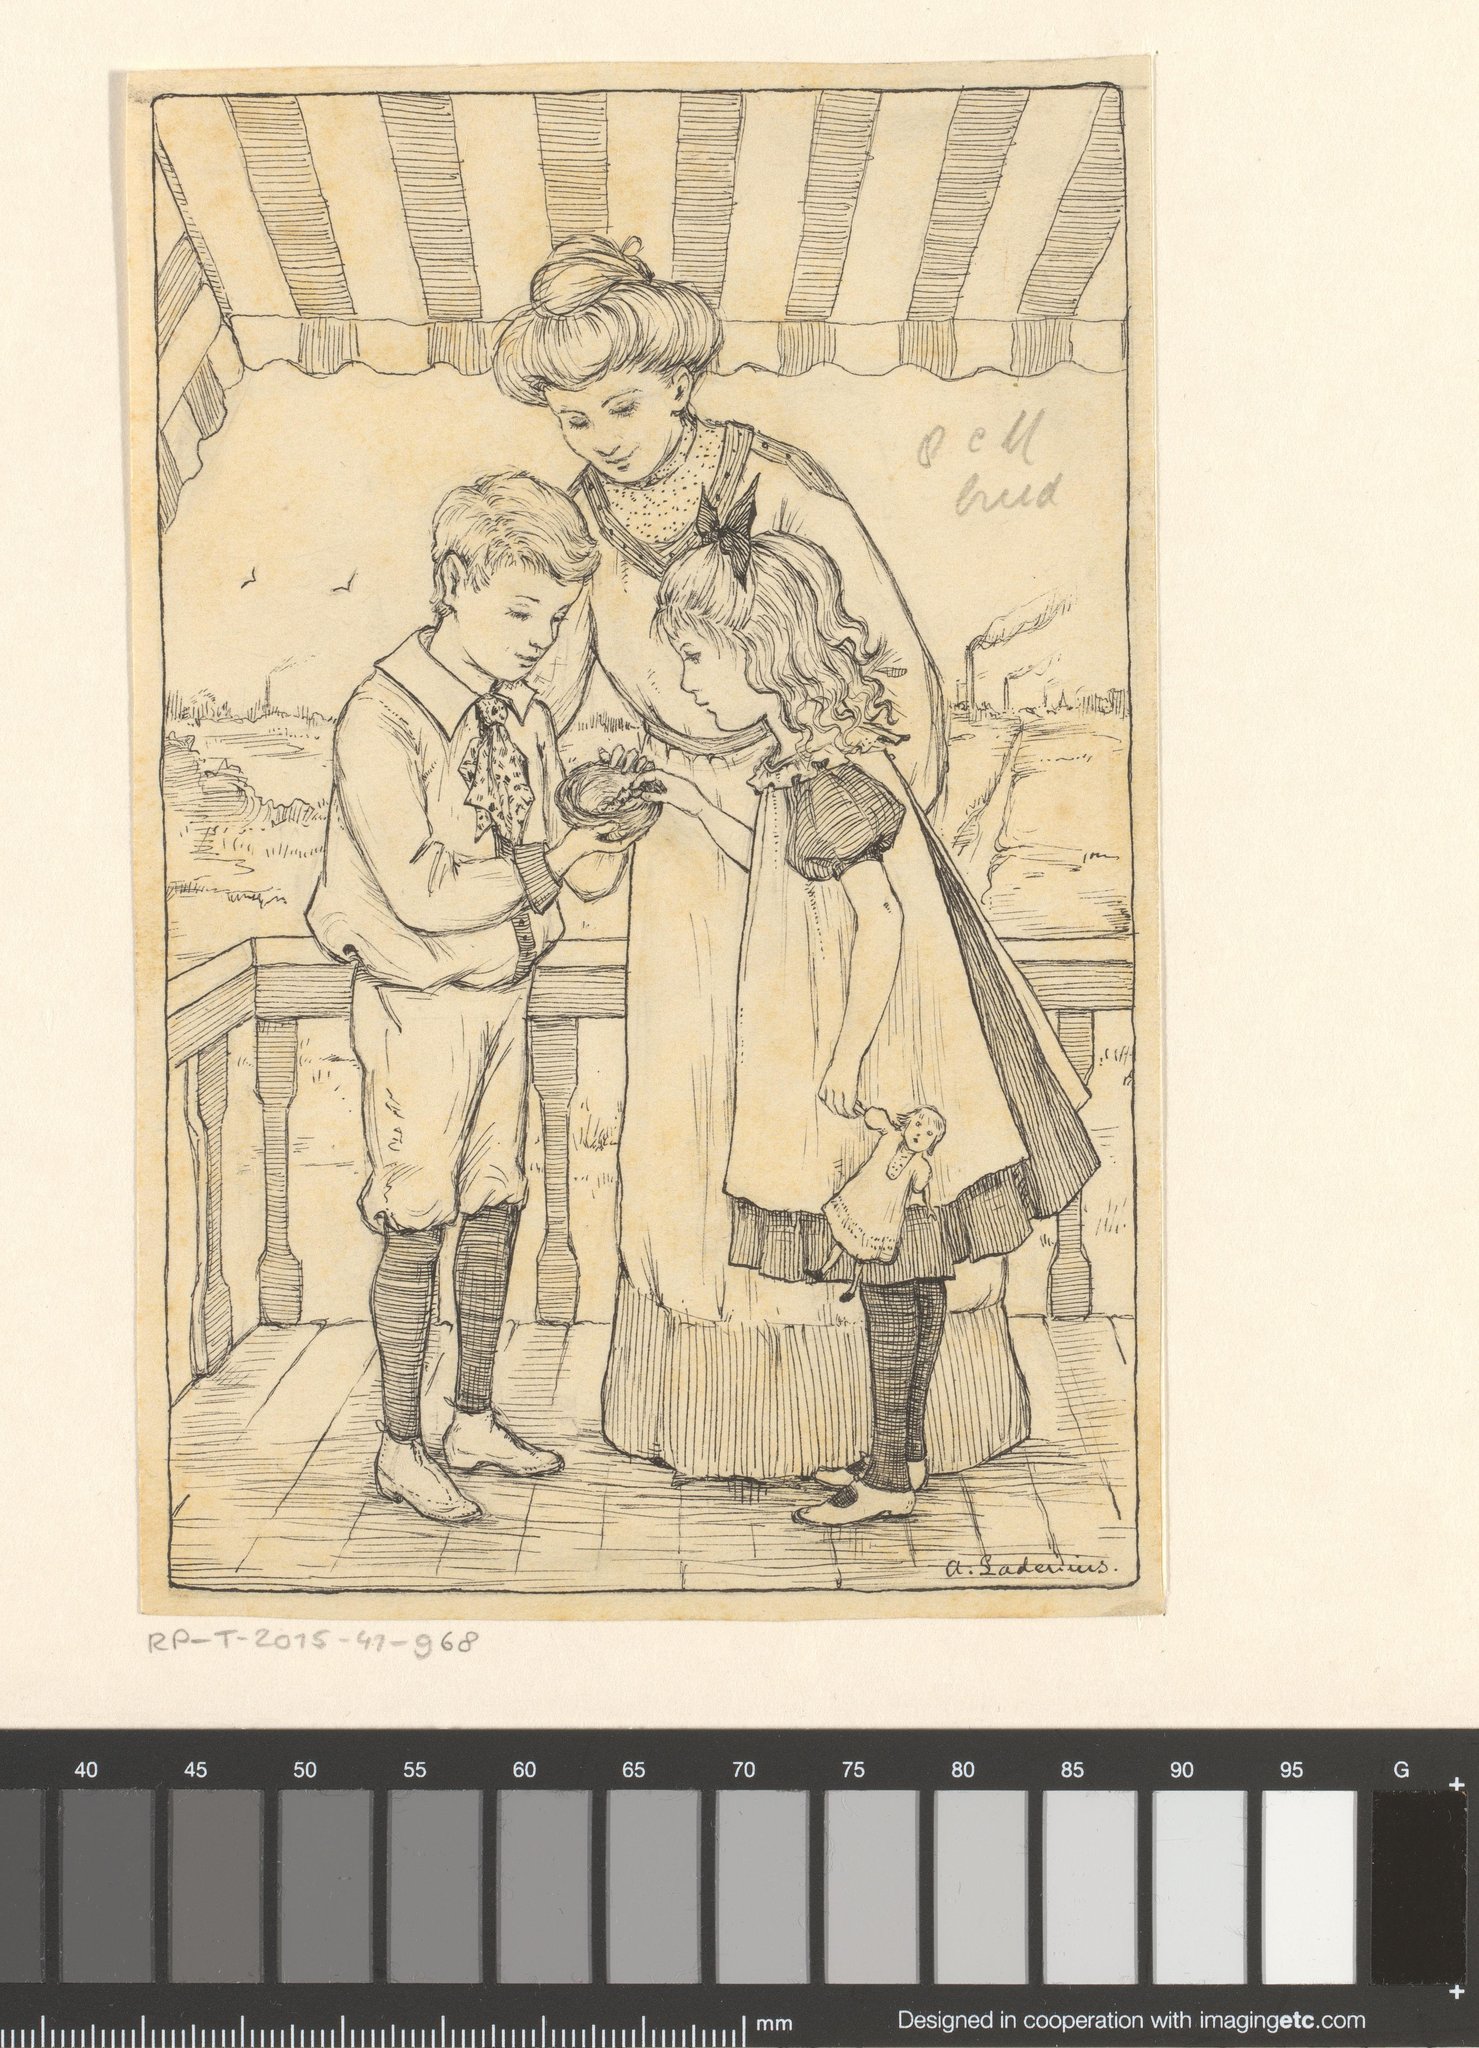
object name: drawing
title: Kinderen en vrouw op een balkon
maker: adri ladenius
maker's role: draughtsman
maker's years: 1883-1953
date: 1893-1953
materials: ink, paper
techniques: pen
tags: child, balcony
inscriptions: collector's mark: Lugt 2228, signature: ‘A. Ladenius.’, number: ‘2’, :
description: Een jongen, meisje en vrouw staan op een balkon onder een luifel. Het meisje houdt een popje in de hand en legt een voorwerp in een nestje of mandje dat de jongen ophoudt.